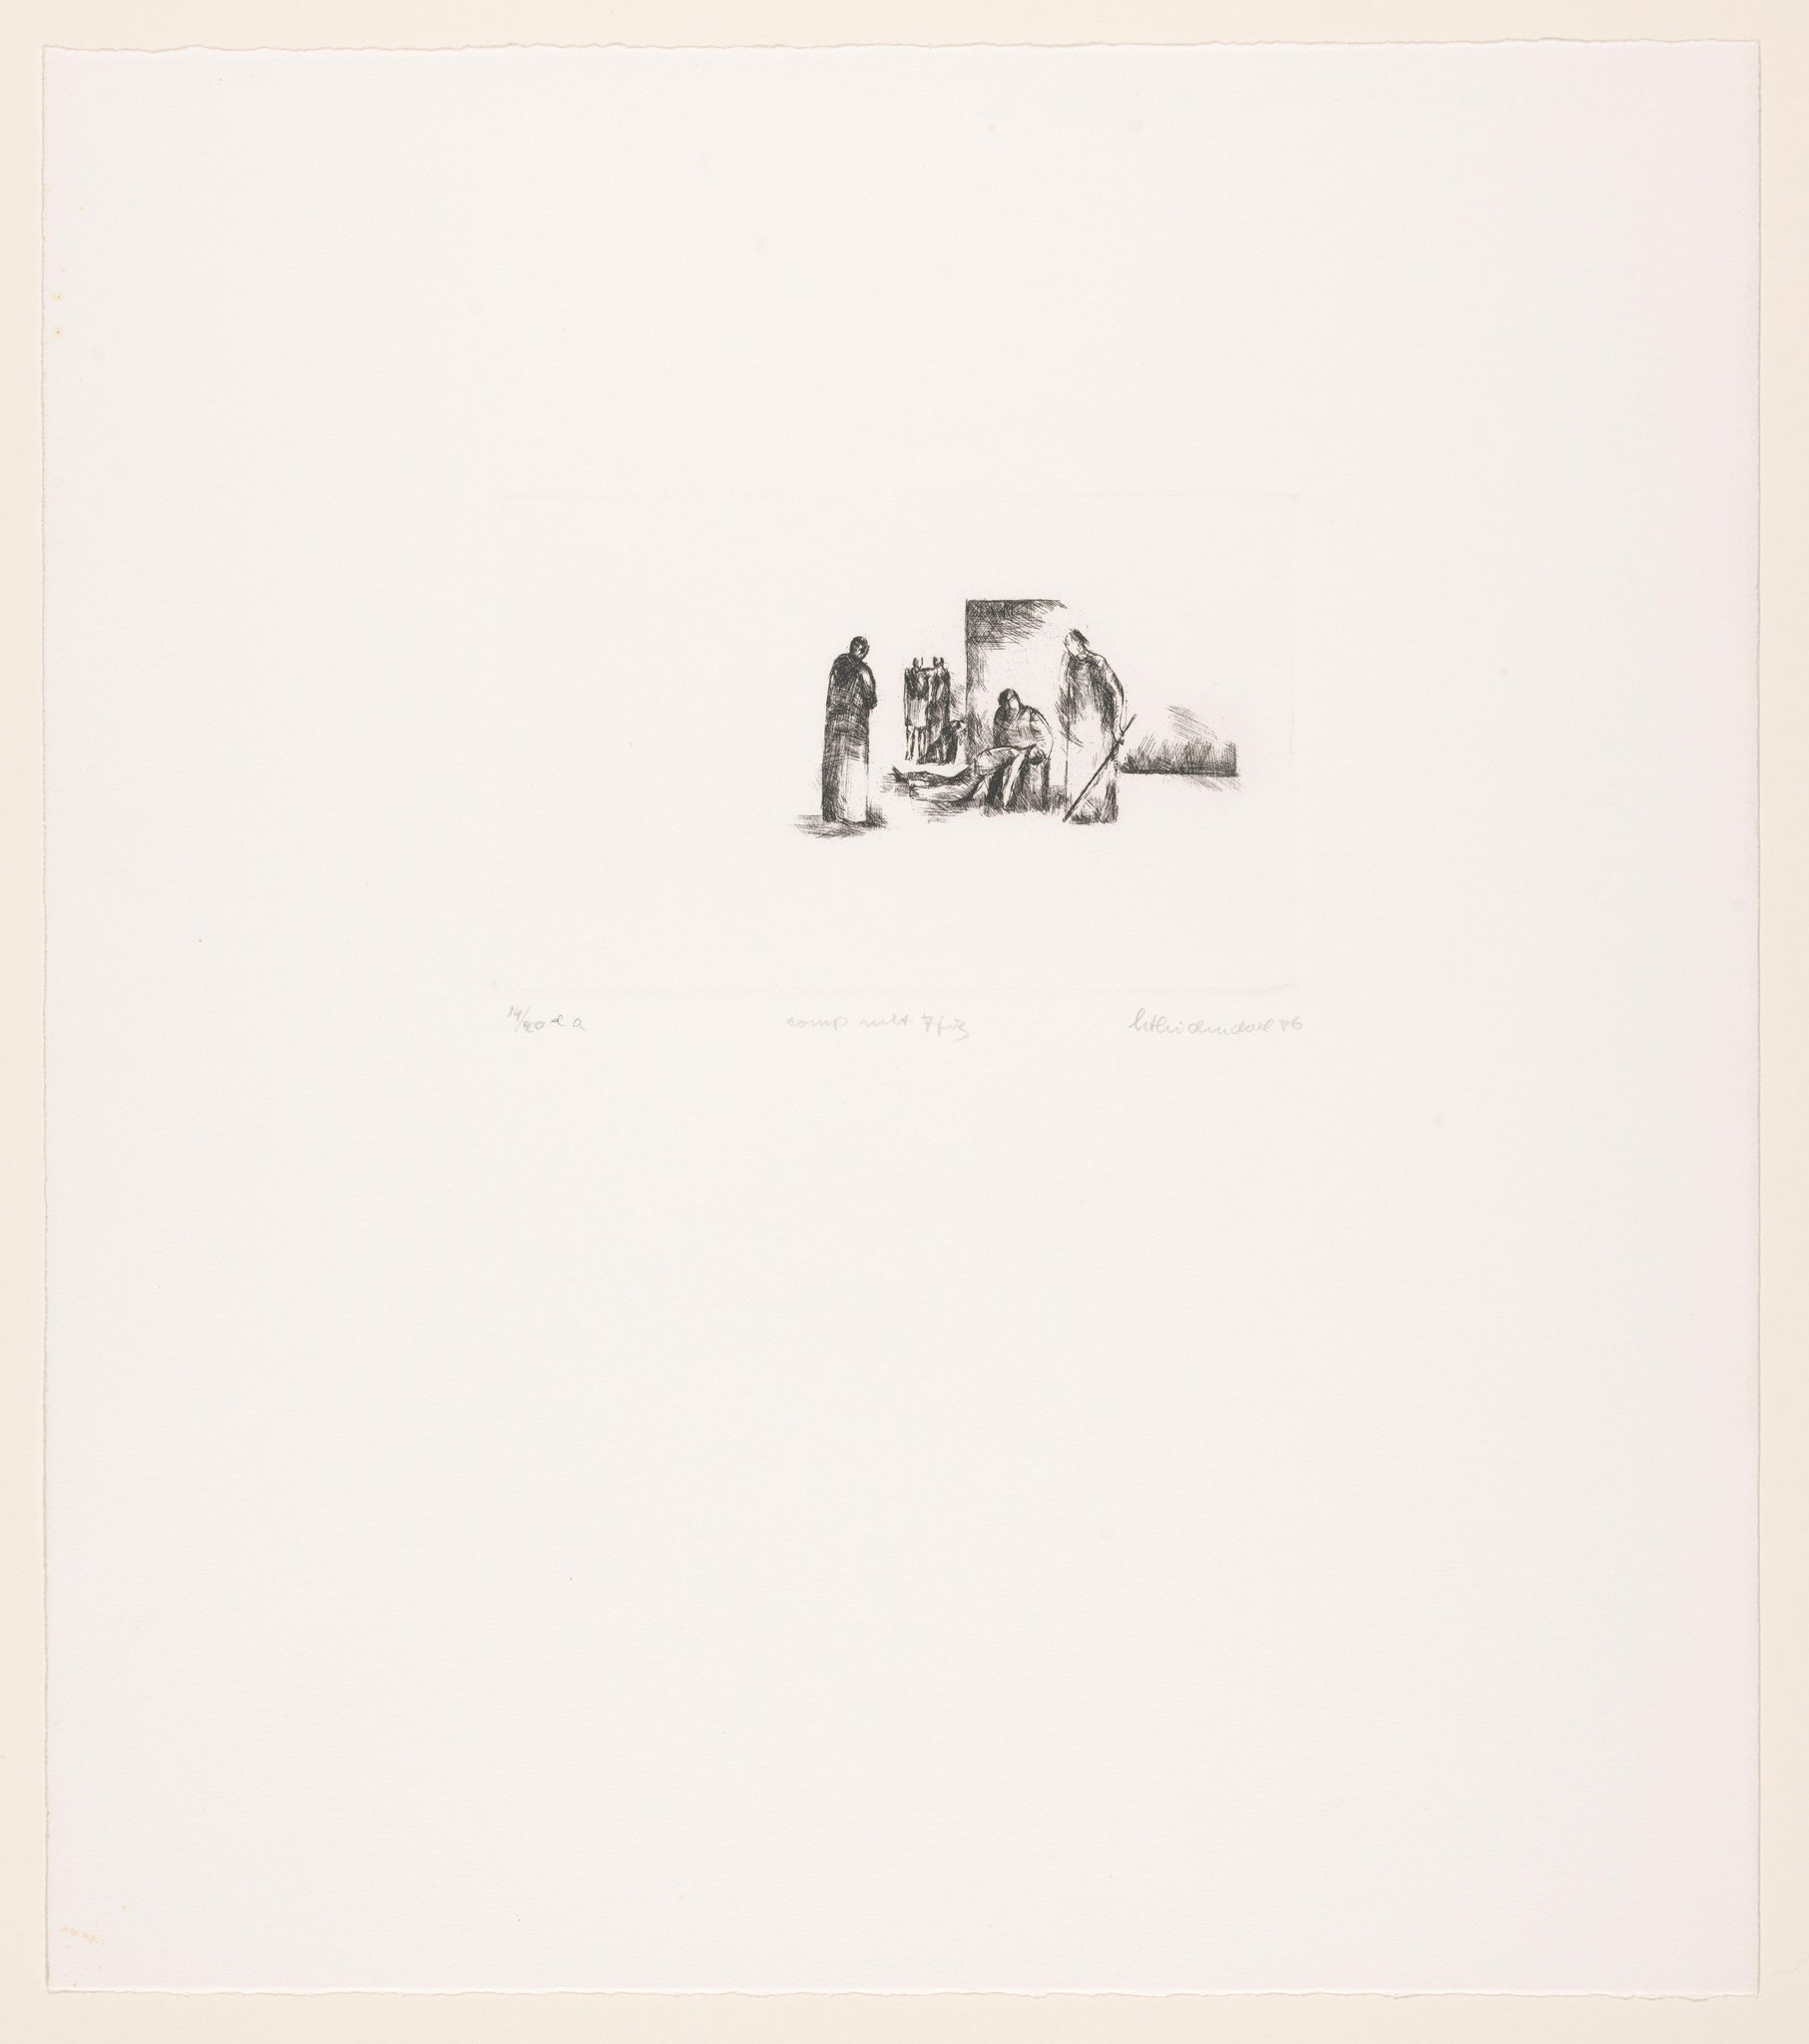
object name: print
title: Compositie met zeven figuren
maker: lau heidendael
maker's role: print maker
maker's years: 1946-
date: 1976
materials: paper, ink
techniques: etching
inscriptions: signature and date: ‘lHeidendael 76’, edition: ‘14/20 e a’, title: ‘compositie met 7 fig’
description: Copositie met zeven figuren waarvan er een een stok vasthoudt en er een in de armen van een ander ligt.